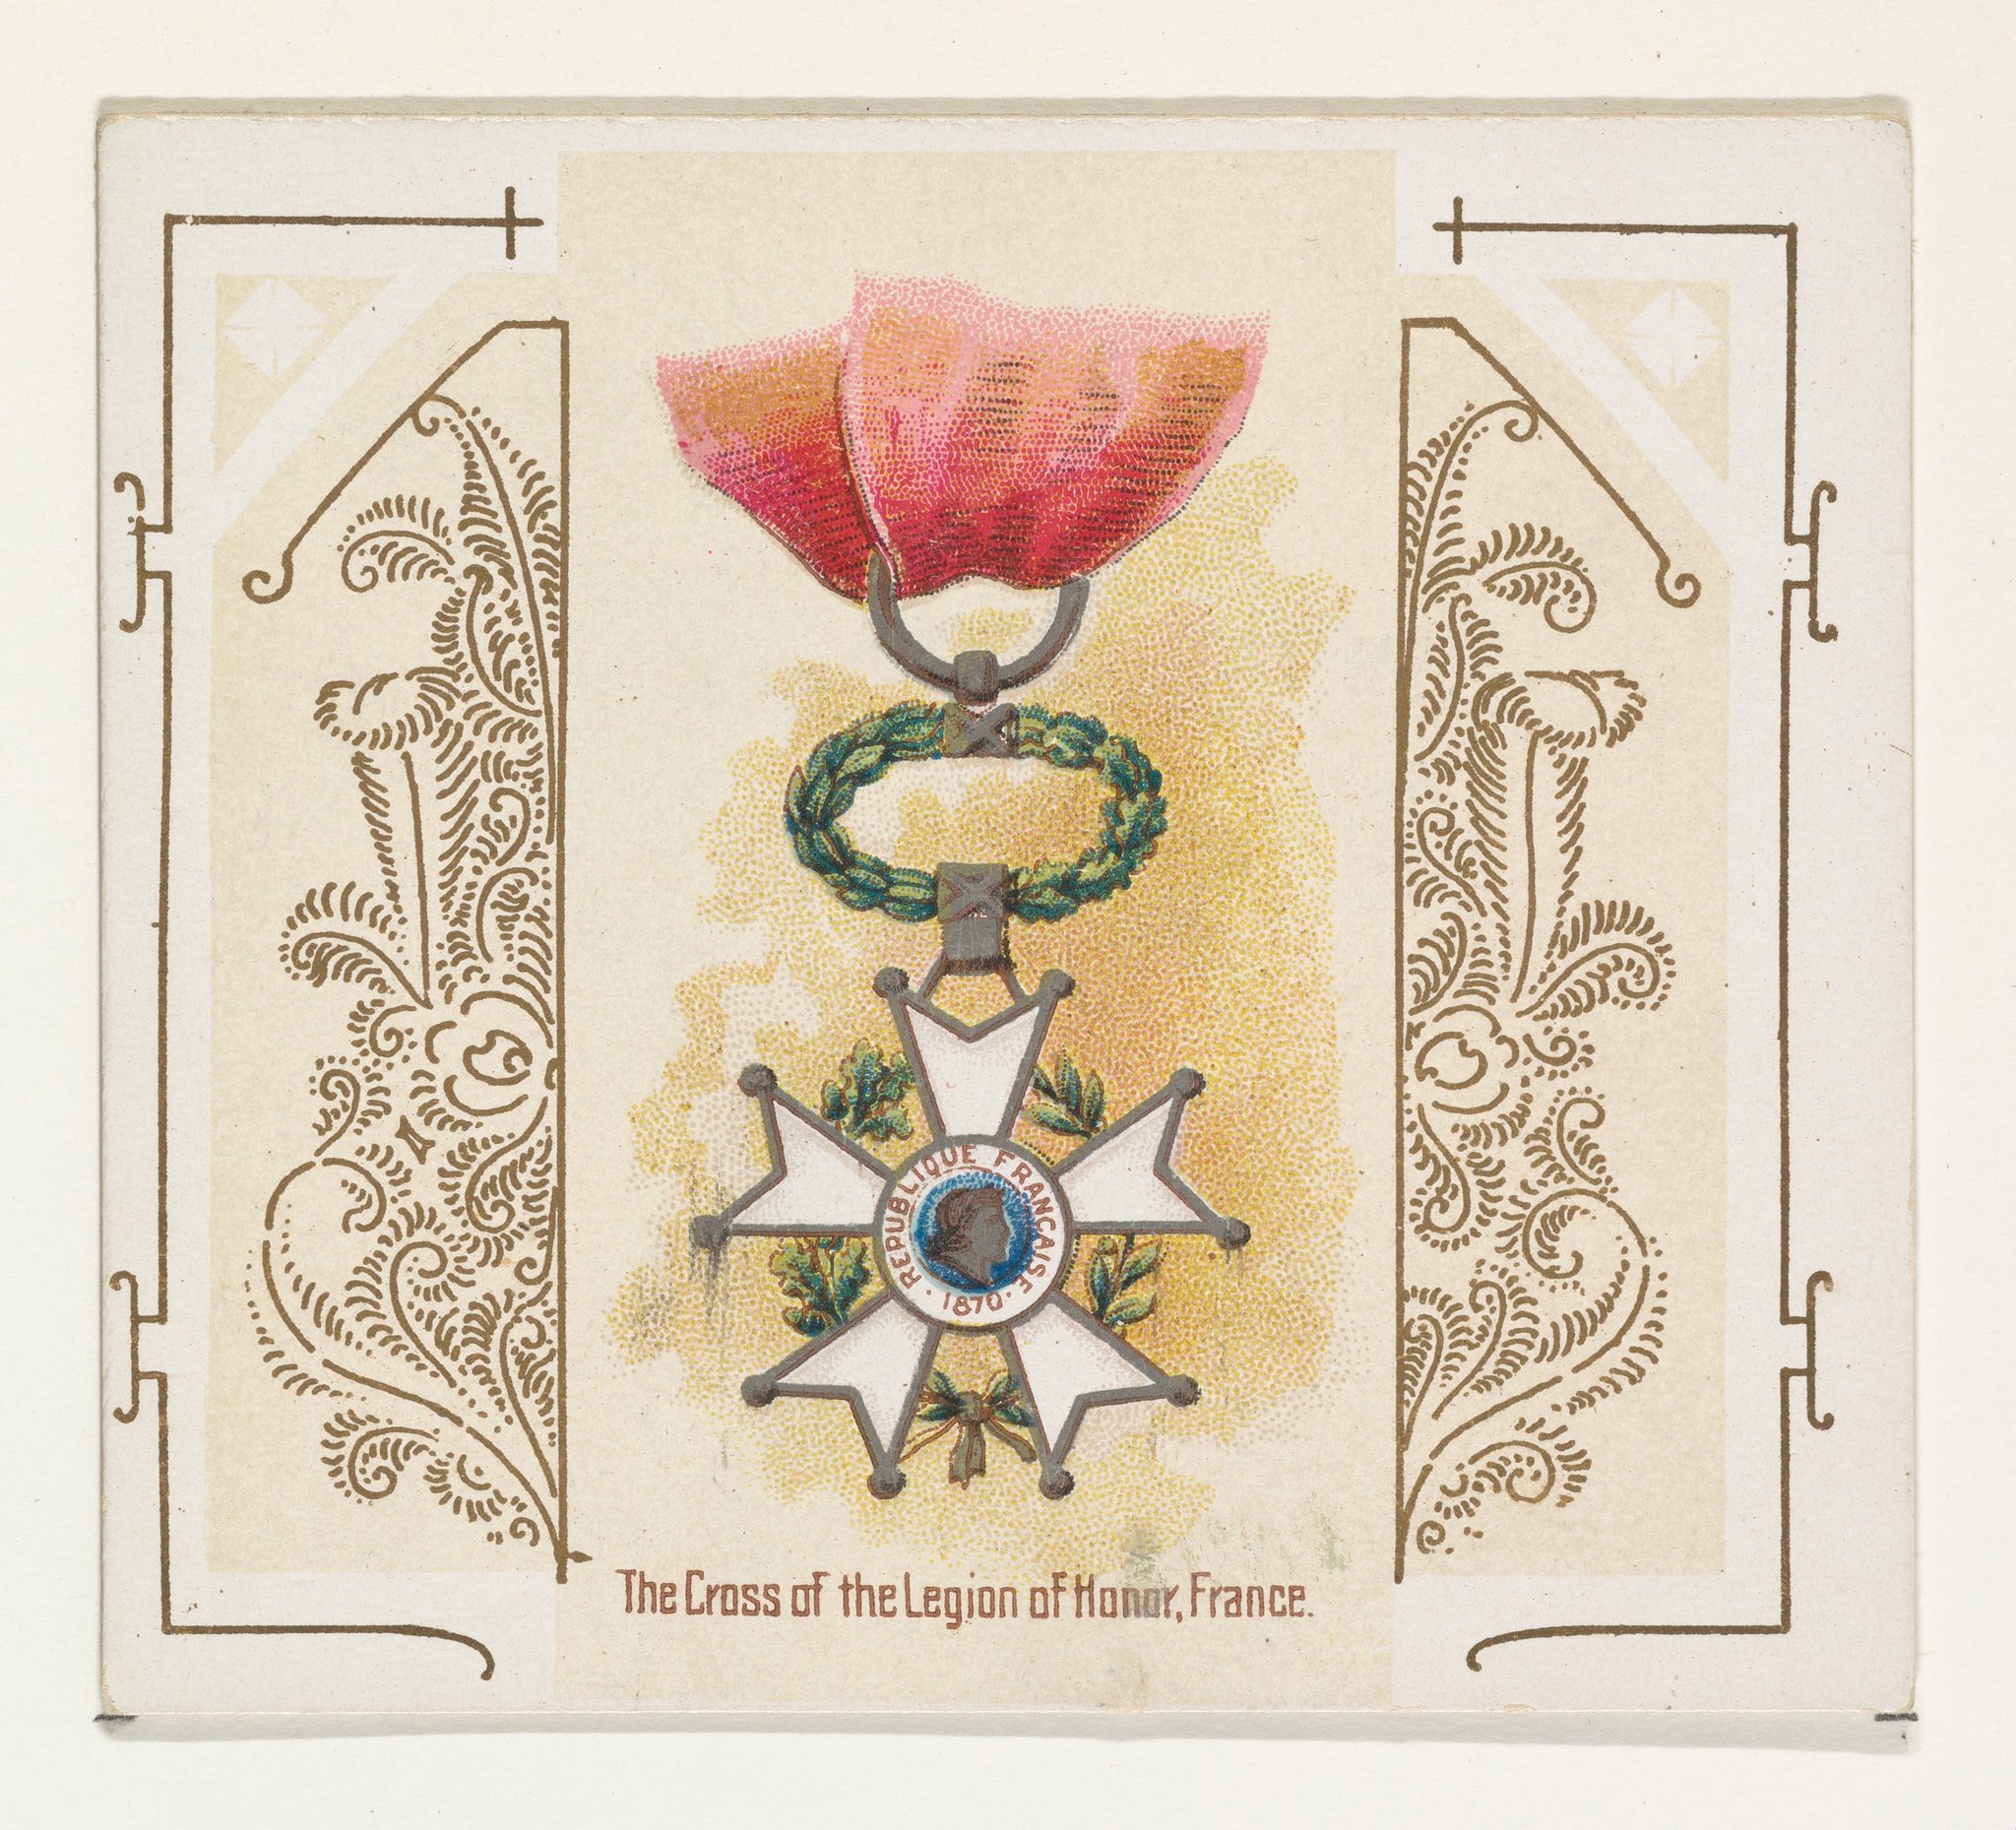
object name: print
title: The Cross of the Legion of Honor, France, from the World's Decorations series (N44) for Allen & Ginter Cigarettes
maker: allen & ginter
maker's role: publisher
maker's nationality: american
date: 1890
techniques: color lithograph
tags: medals